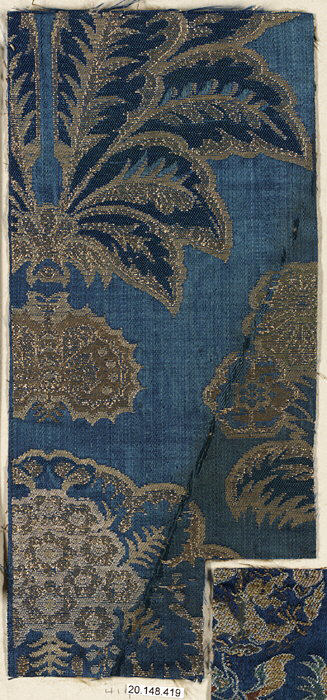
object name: piece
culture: chinese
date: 1701-1733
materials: silk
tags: flowers,leaves